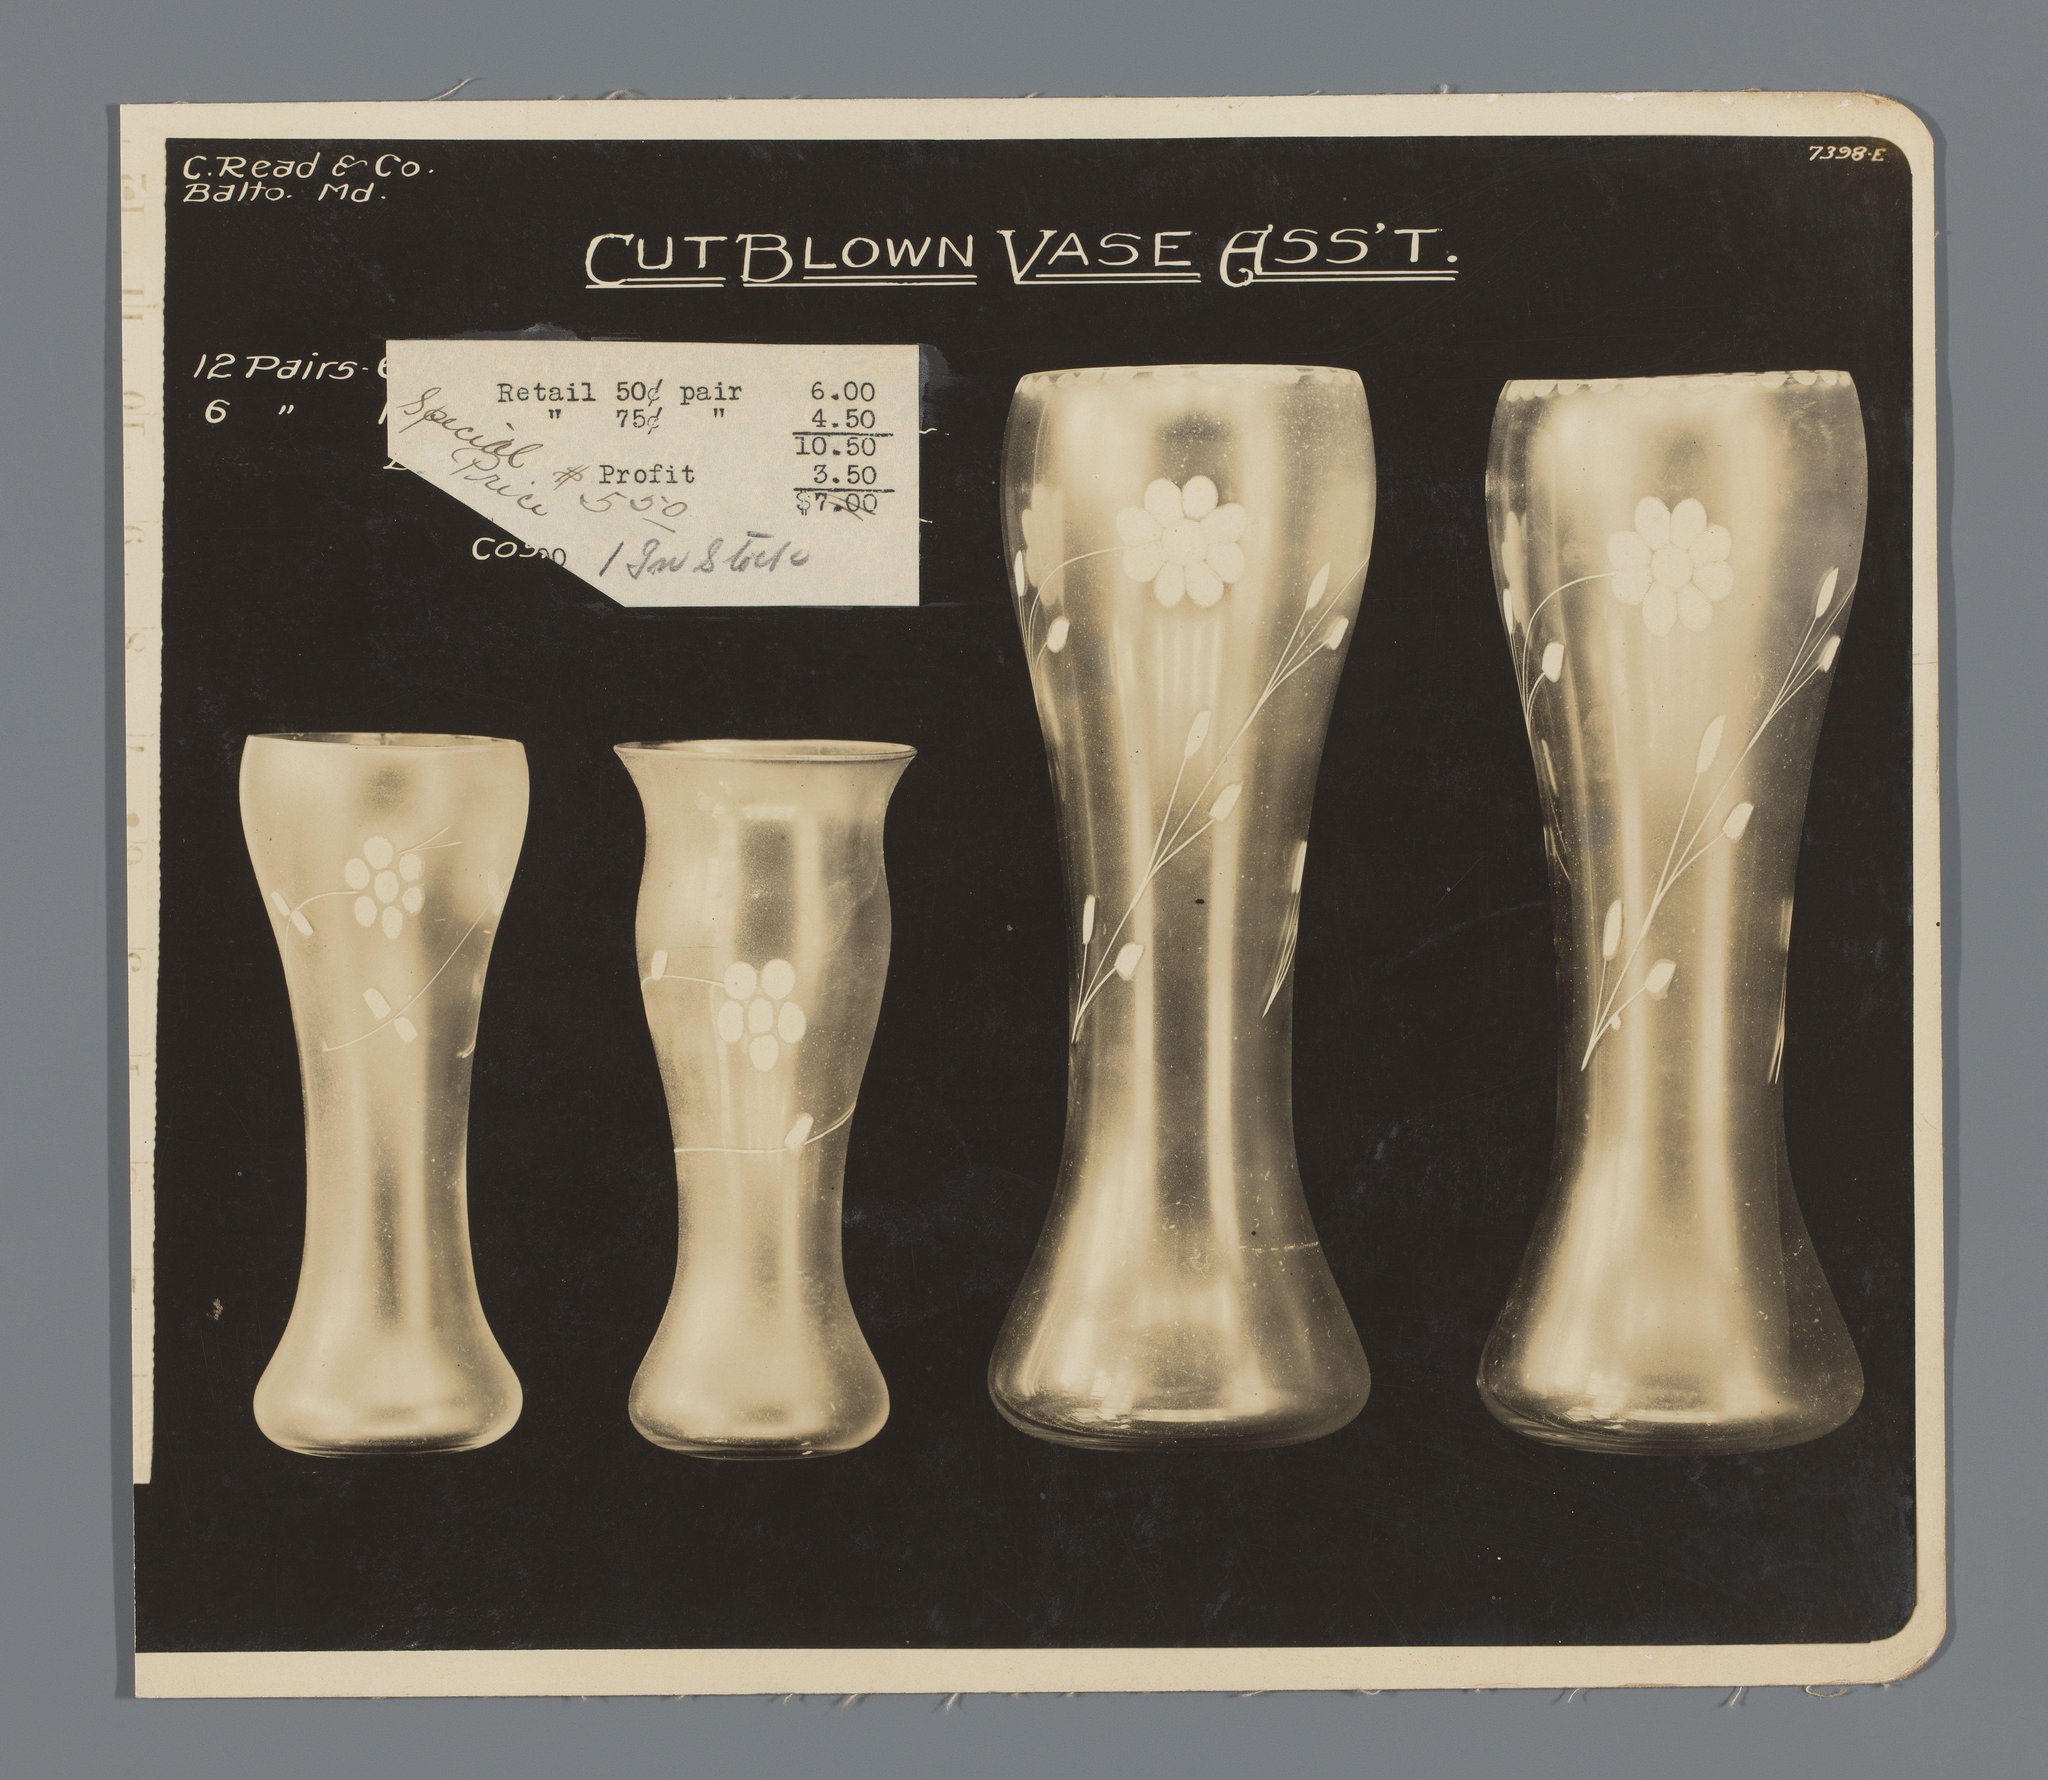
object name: photograph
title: Reclamefoto met serviezen en keukengerei van de firma C. Read & Co., Baltimore, Maryland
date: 1920-1930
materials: paper, textile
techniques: photography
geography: united states